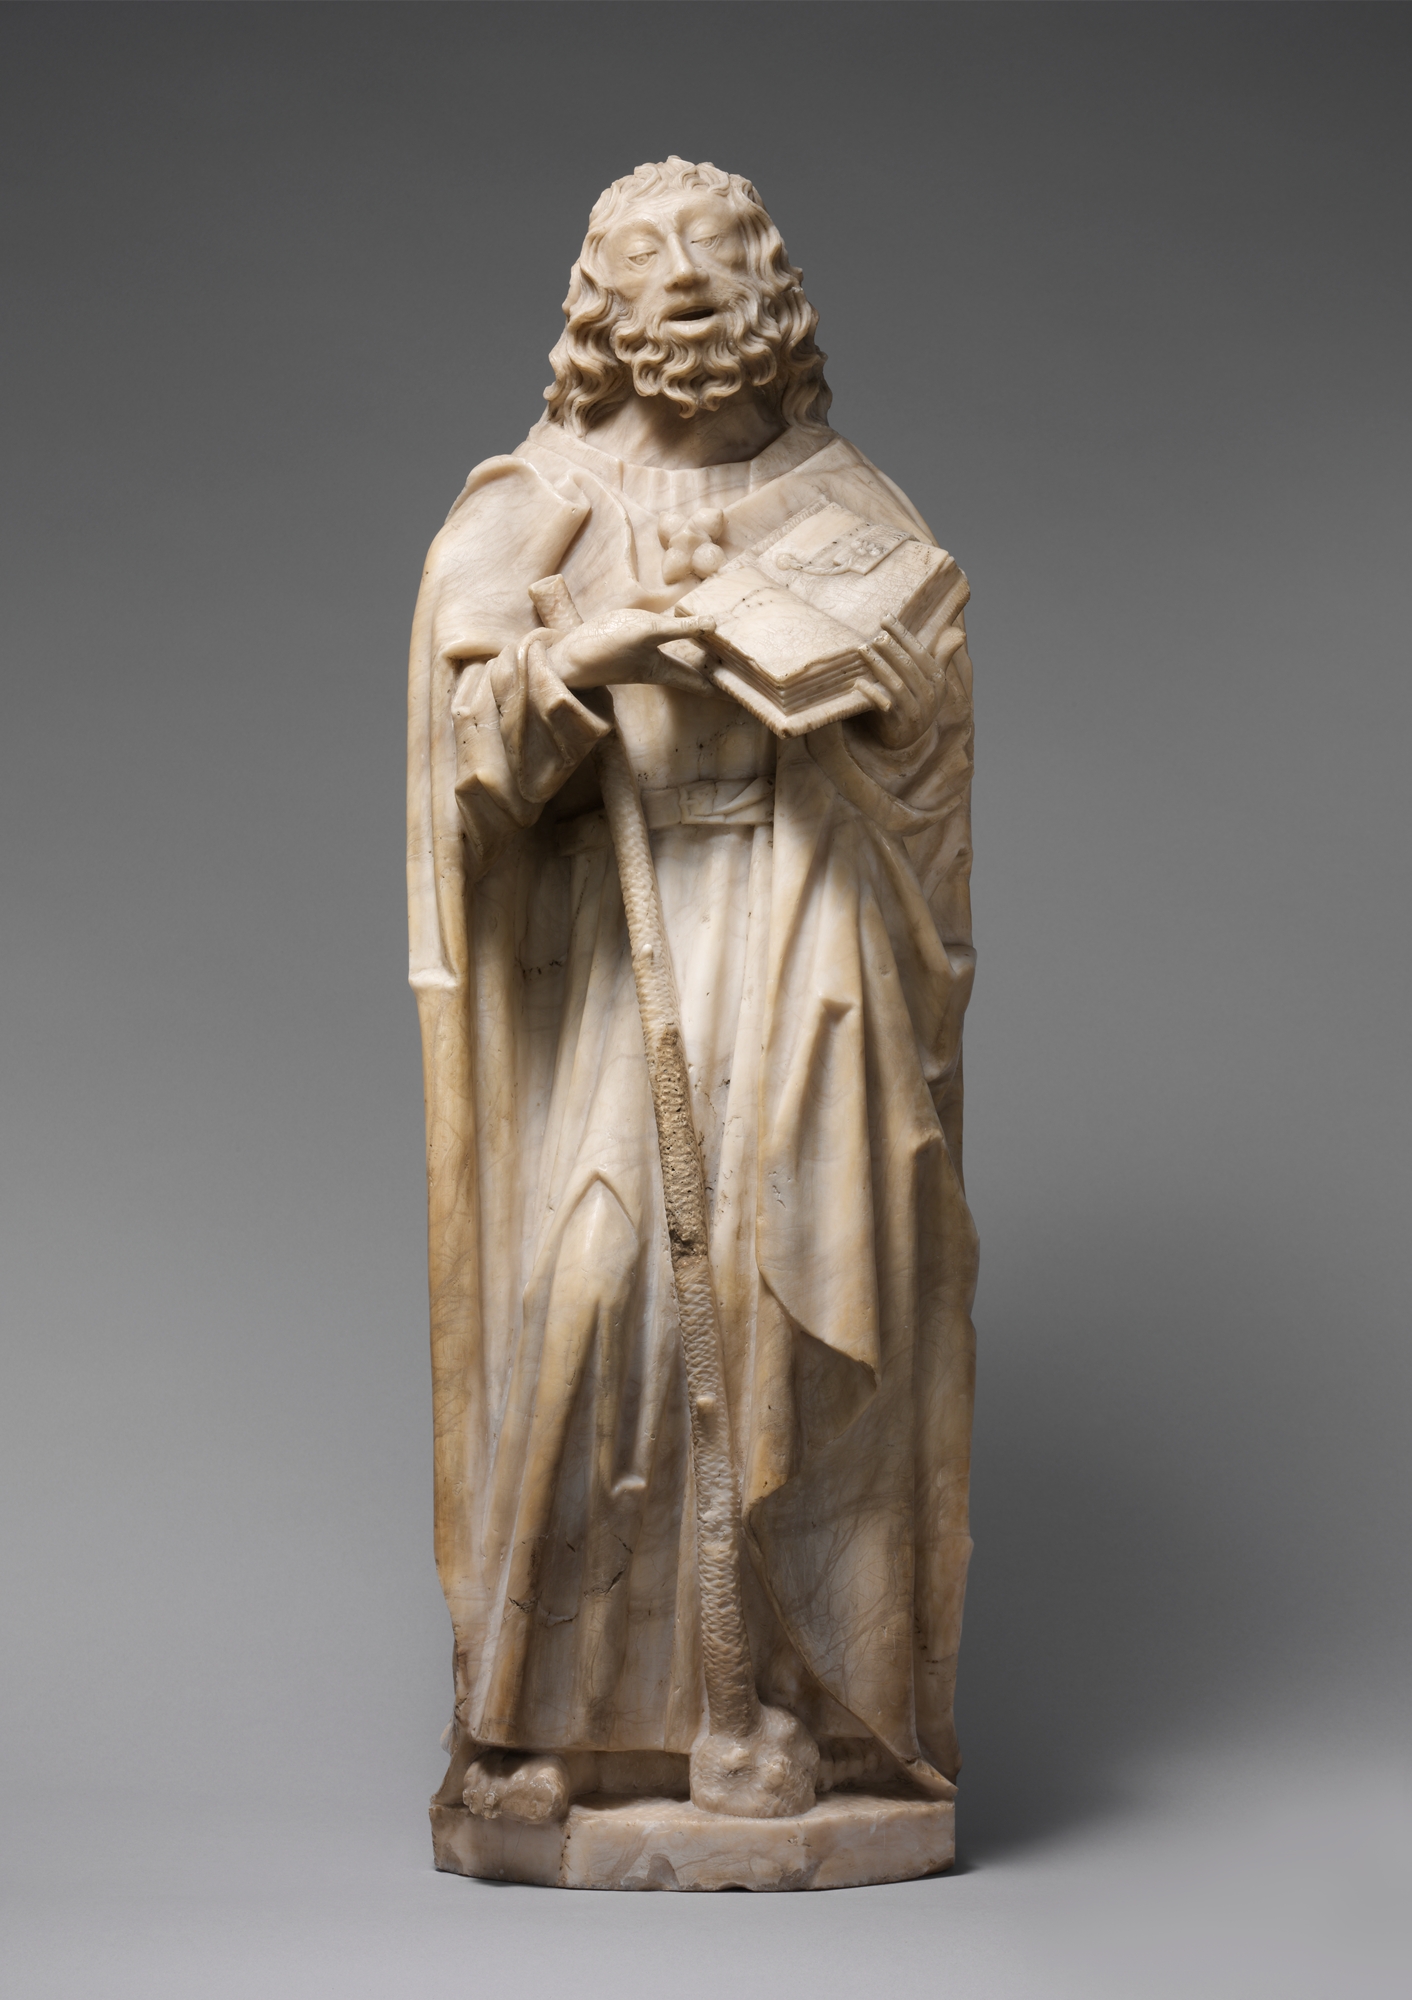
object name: statuette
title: Saint James the Lesser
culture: spanish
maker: gil de siloe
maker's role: artist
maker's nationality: spanish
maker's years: 1475-1505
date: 1500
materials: alabaster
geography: spain